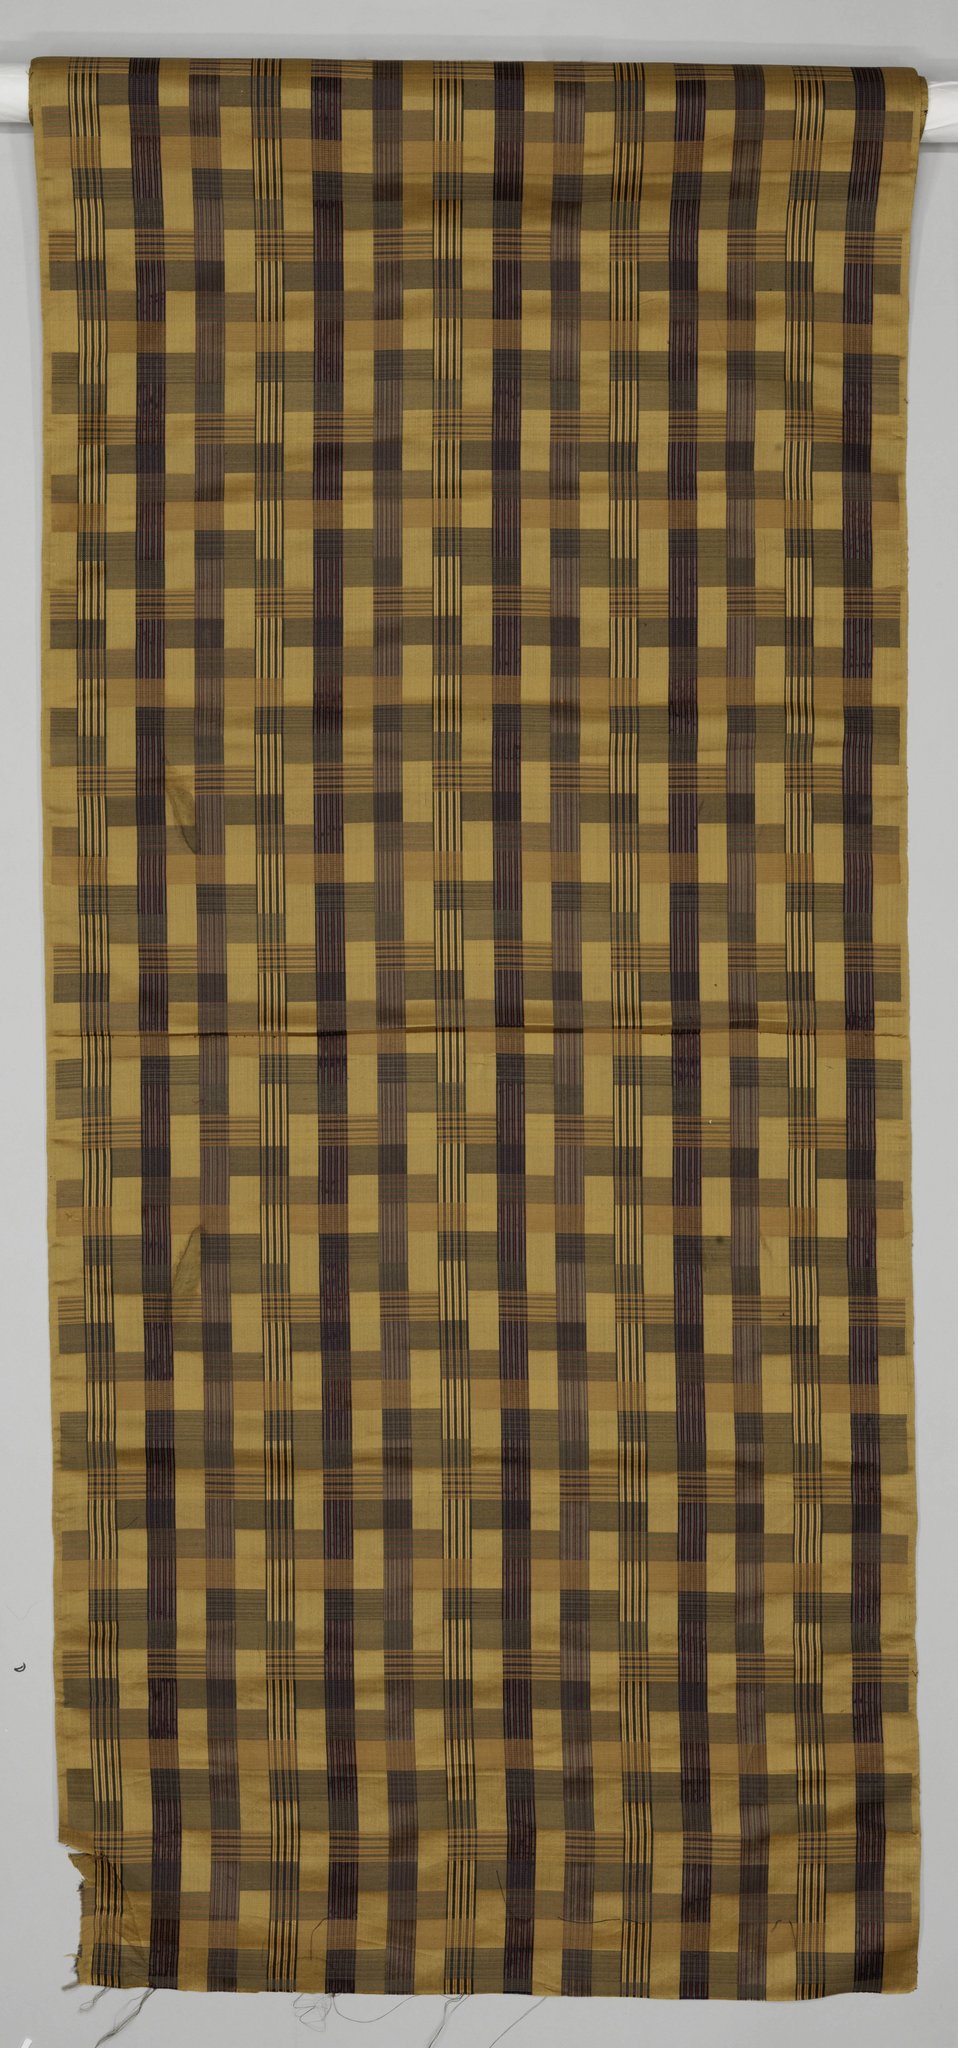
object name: silk textile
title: Baan zijdedamast met een dessin van blokken en strepen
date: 1900-1920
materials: silk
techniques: damask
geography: japan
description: Baan zijdedamast met een dessin van blokken en strepen in blauw, rood, bruingrijs en zwart op goudgele fond. Oosters textiel.